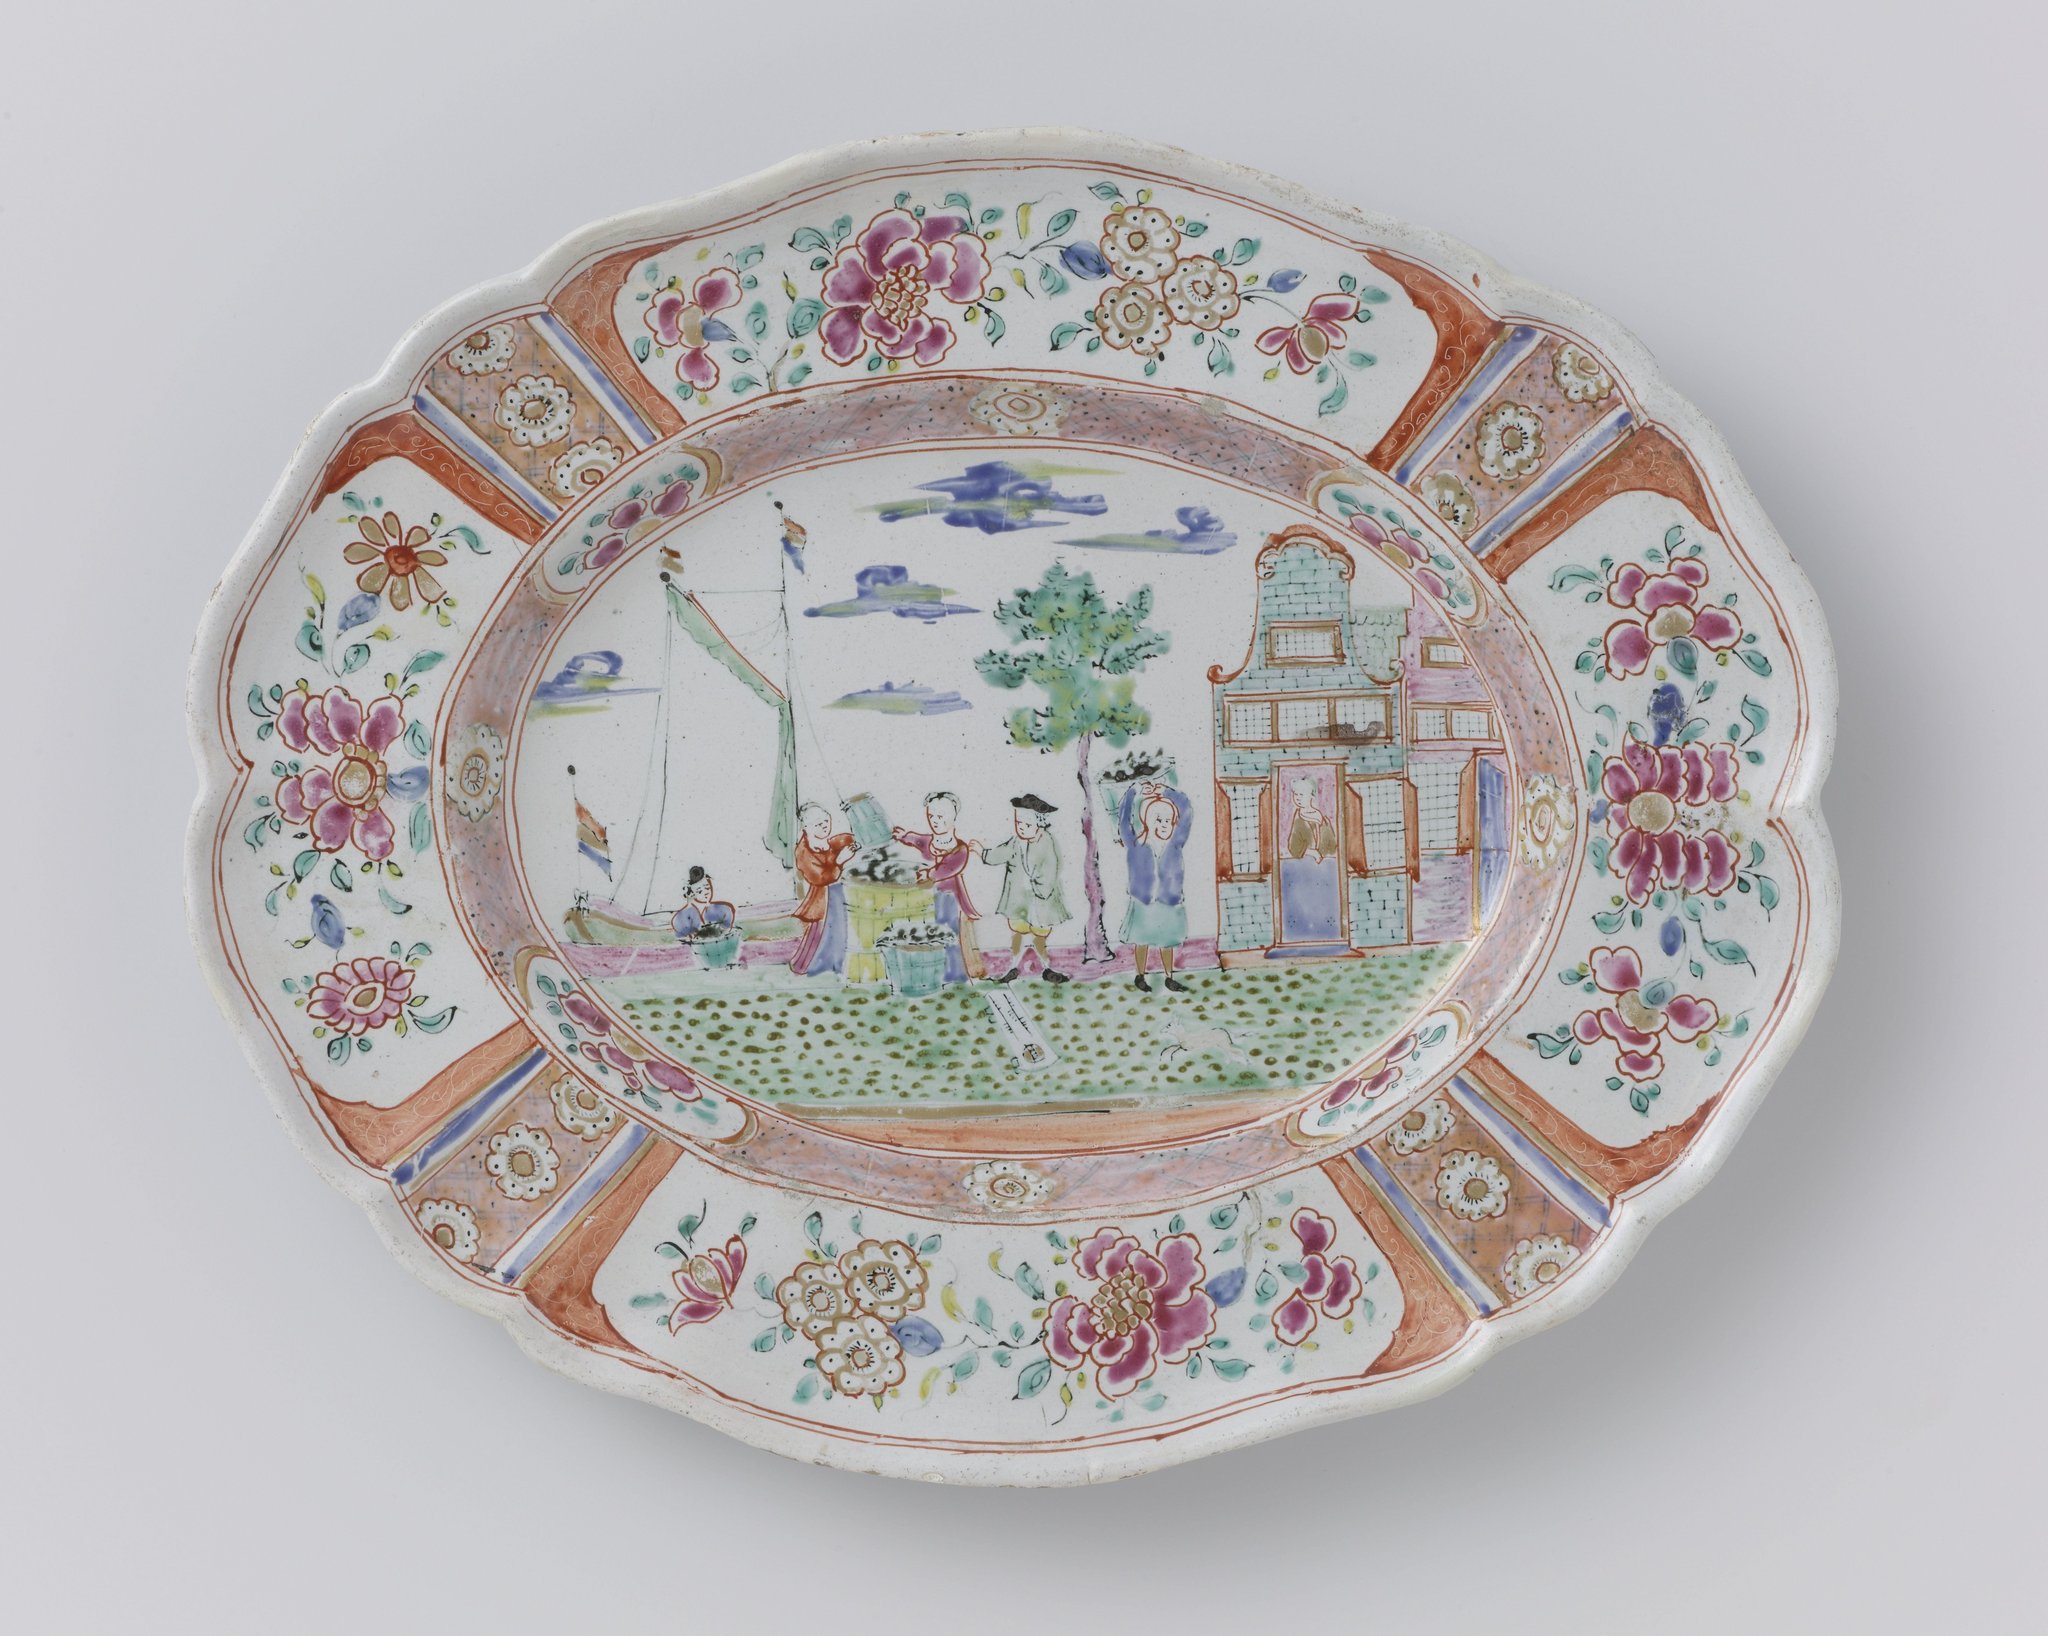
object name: platter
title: Ovale schotel met havenscène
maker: Anonymous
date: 1760-1800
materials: faience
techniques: kiln, painted, polychromy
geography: delft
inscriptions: collector's mark: ‘collection J.F. Loudon’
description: Ovale schotel veelkleurig beschilderd met een havenscène. Langs de rand vakken met bloemstukken.